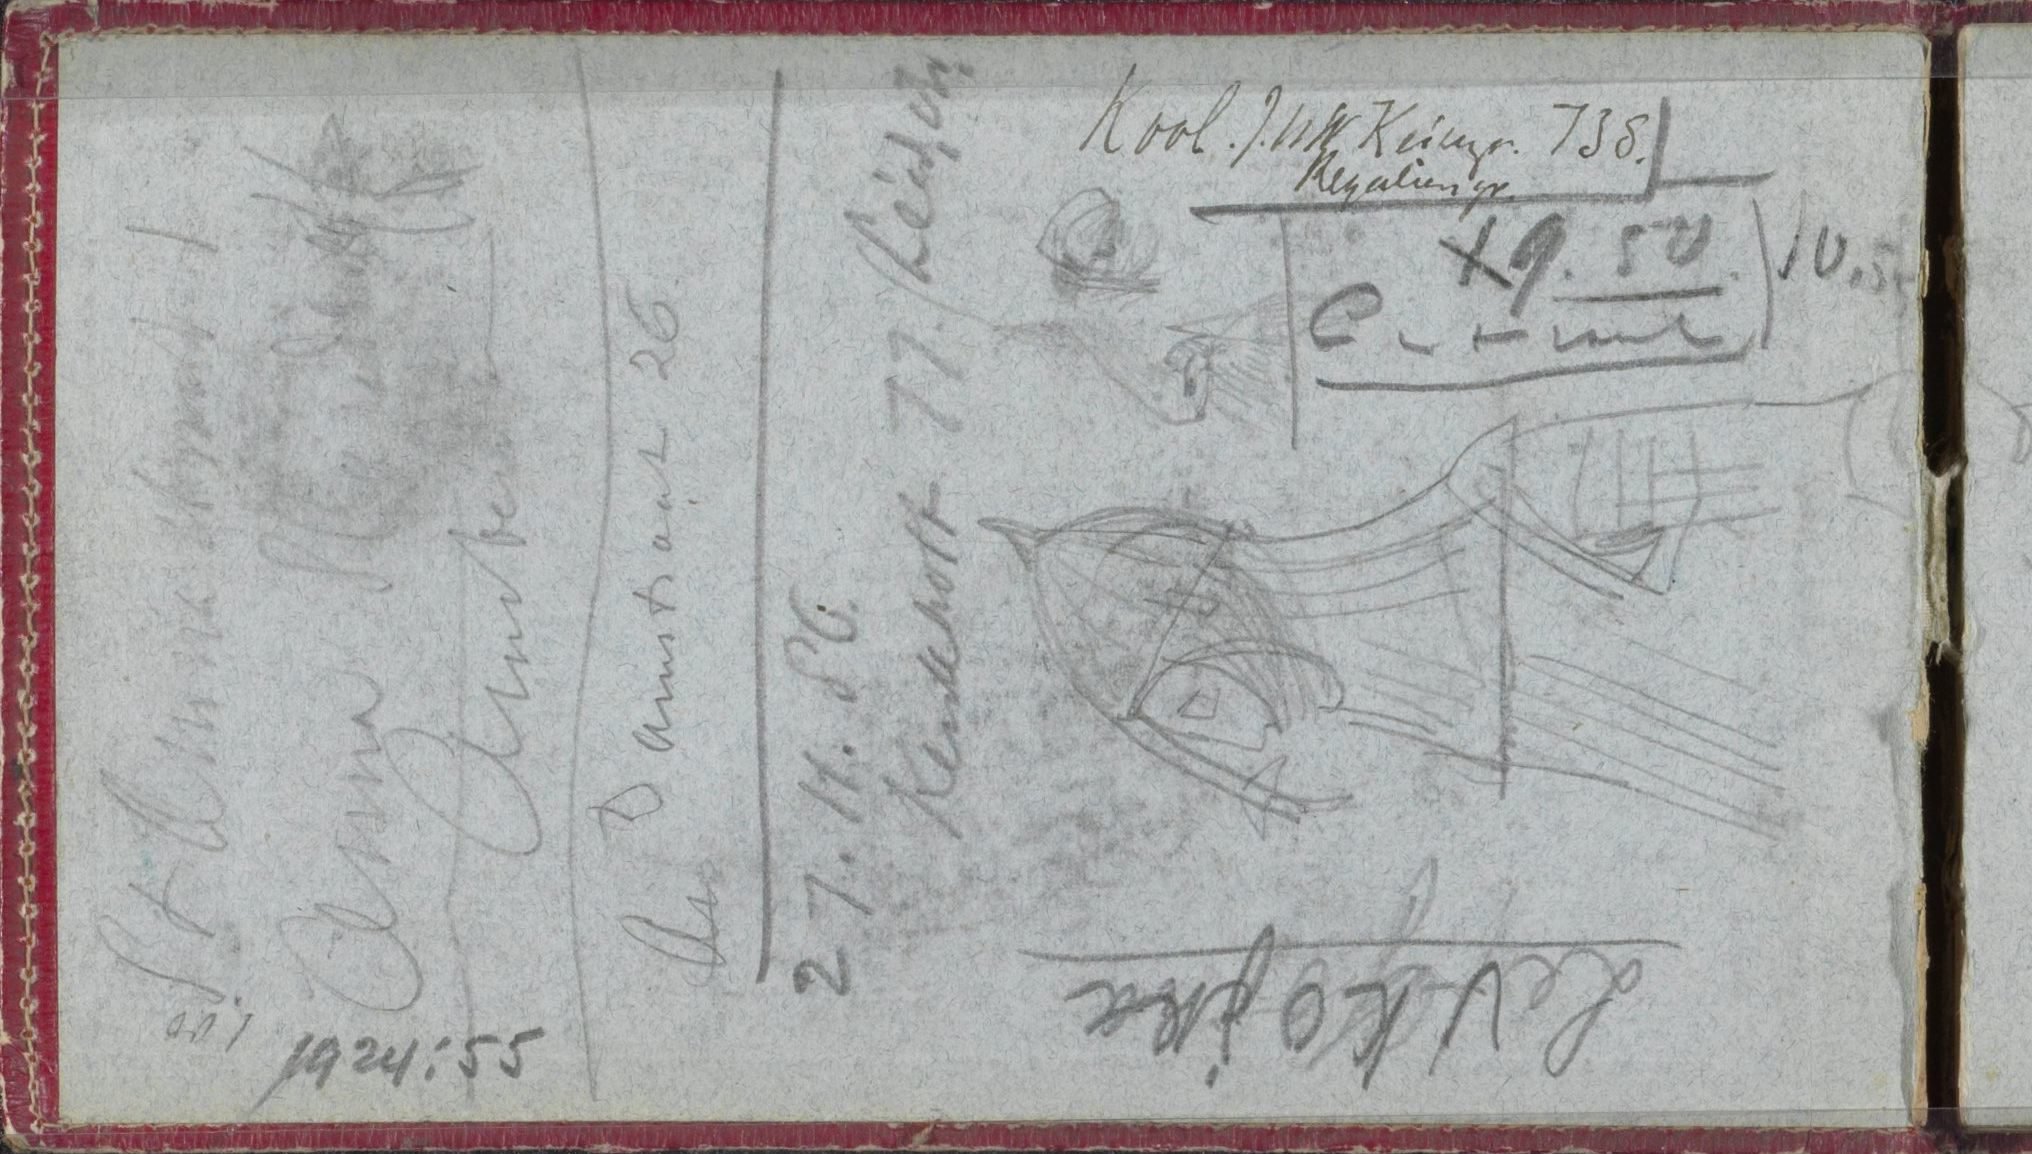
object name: endleaf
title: Soldaat en een mannengezicht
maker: george hendrik breitner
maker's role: draughtsman, painter, print maker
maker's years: 1857-1923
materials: paper, pencil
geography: amsterdam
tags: helmet, face, the soldier; the soldier's life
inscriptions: annotation: ‘St. Annastraat 1/ Anna Sla[...]/ Amsterdam/ Damstraat 26/ 27.11.86/ Kerkhoff 77. Leidsch/ Levkoj[...]/ Kool. J.NW Keizersgr. 738./ Reguliersgr./ [...]’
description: Pagina 1, voorste schutblad, uit een schetsboek met 32 bladen.